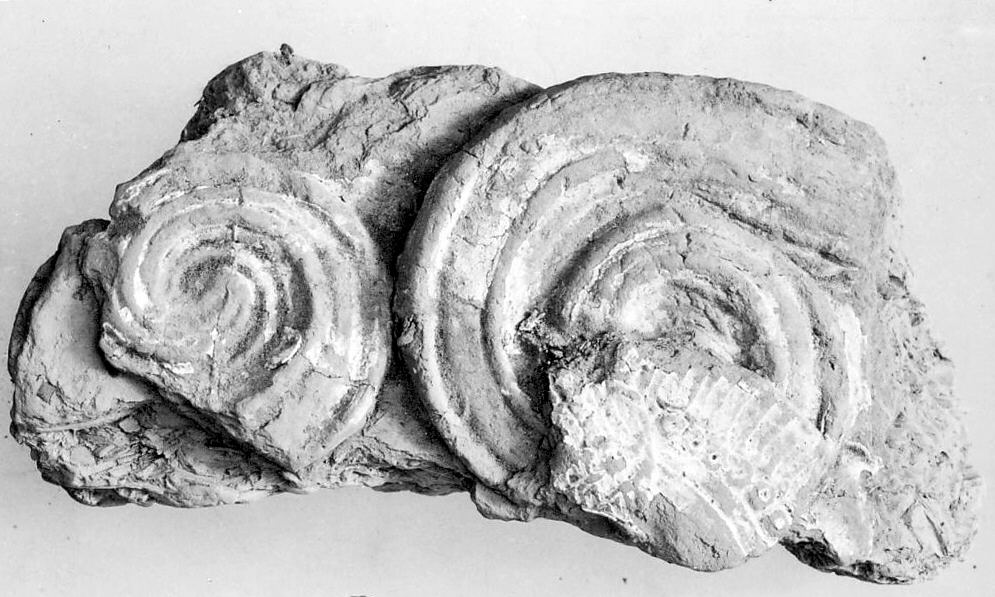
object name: relief fragment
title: Fragment of a Relief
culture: central asian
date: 201-700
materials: clay